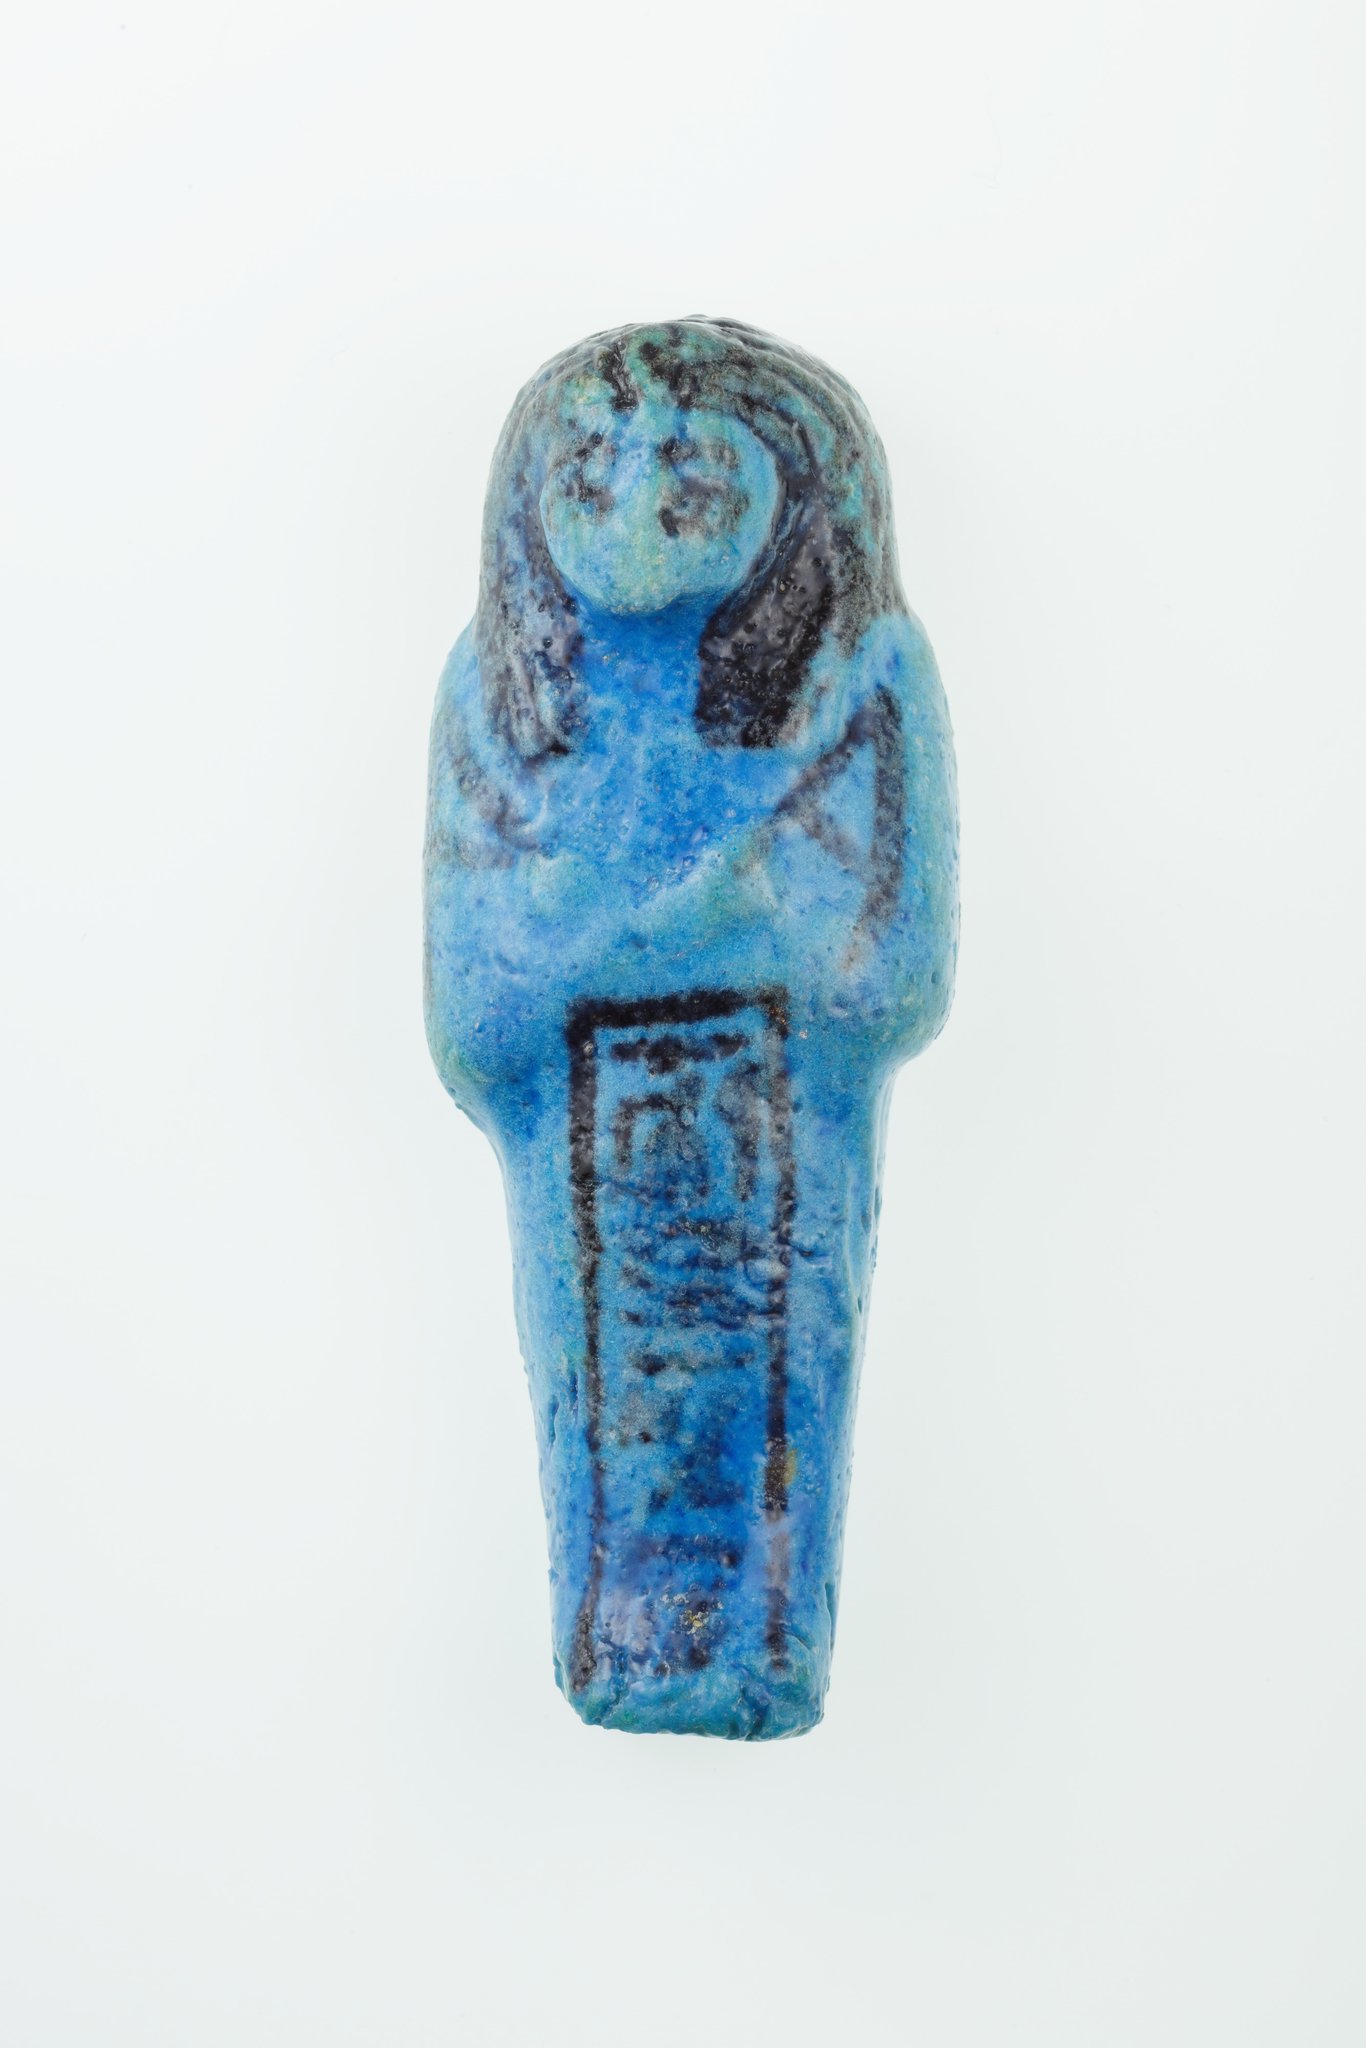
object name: shabti, worker, nauny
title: Worker Shabti of Nauny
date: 1050 BCE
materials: faience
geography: egypt